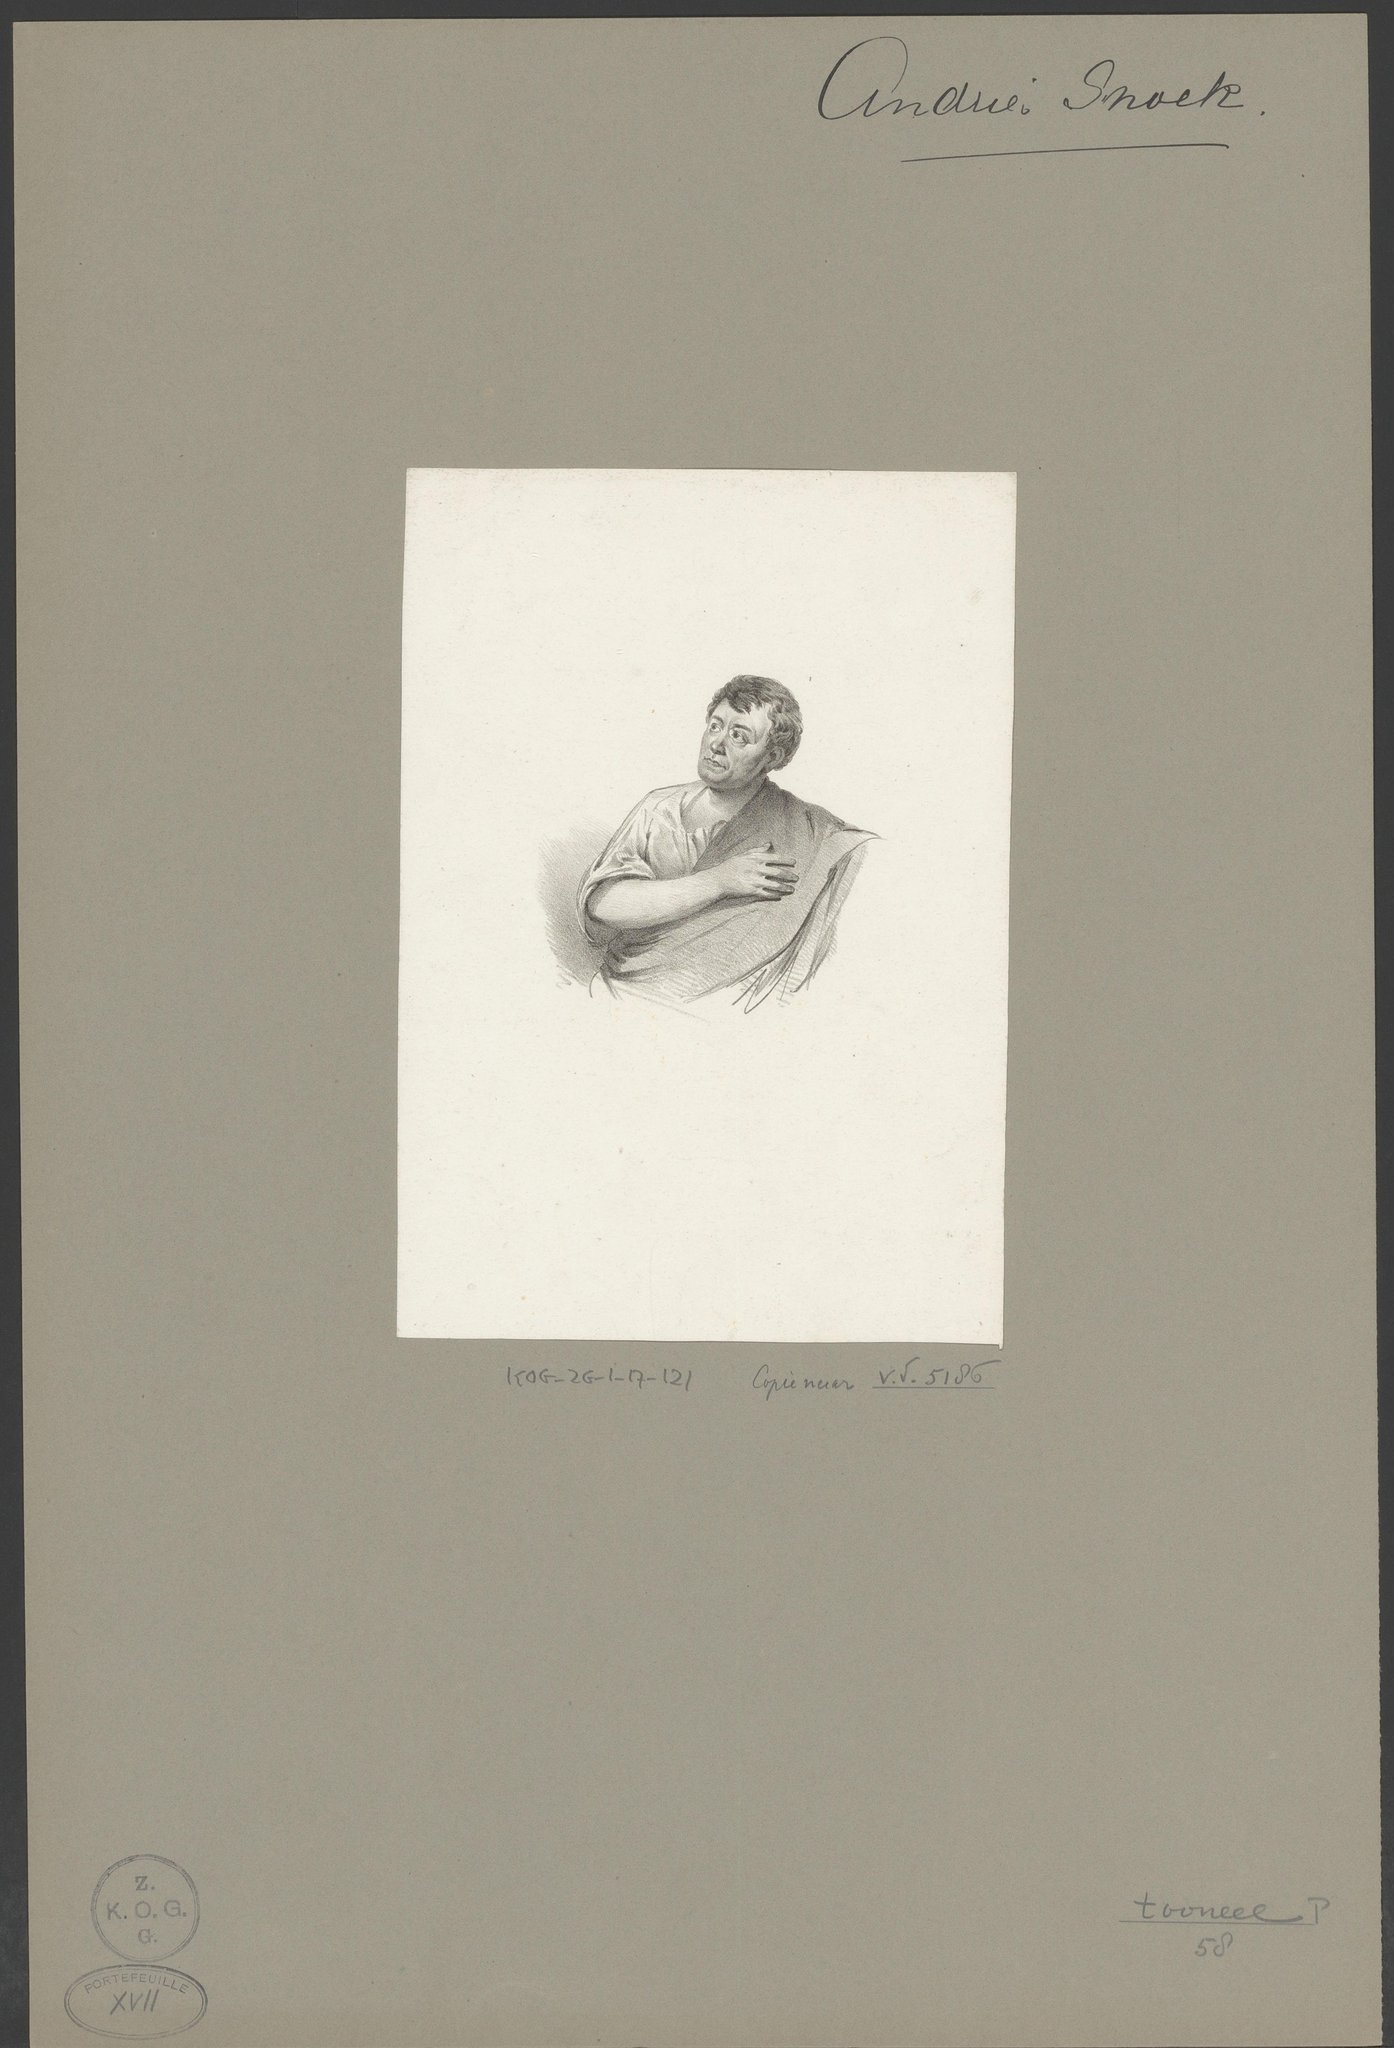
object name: print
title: Portret van Andreas Snoek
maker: Anonymous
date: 1828-1849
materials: paper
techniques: lithograph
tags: rotterdam, amsterdam, historical persons, portrait of actor, actress, actor (on the stage)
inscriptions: stamp, collector's mark: Lugt 1641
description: Onderwerpsrubrieken binnen de Atlas Zeden en Gewoonten: Tooneel, Portretten van toneelspelers.